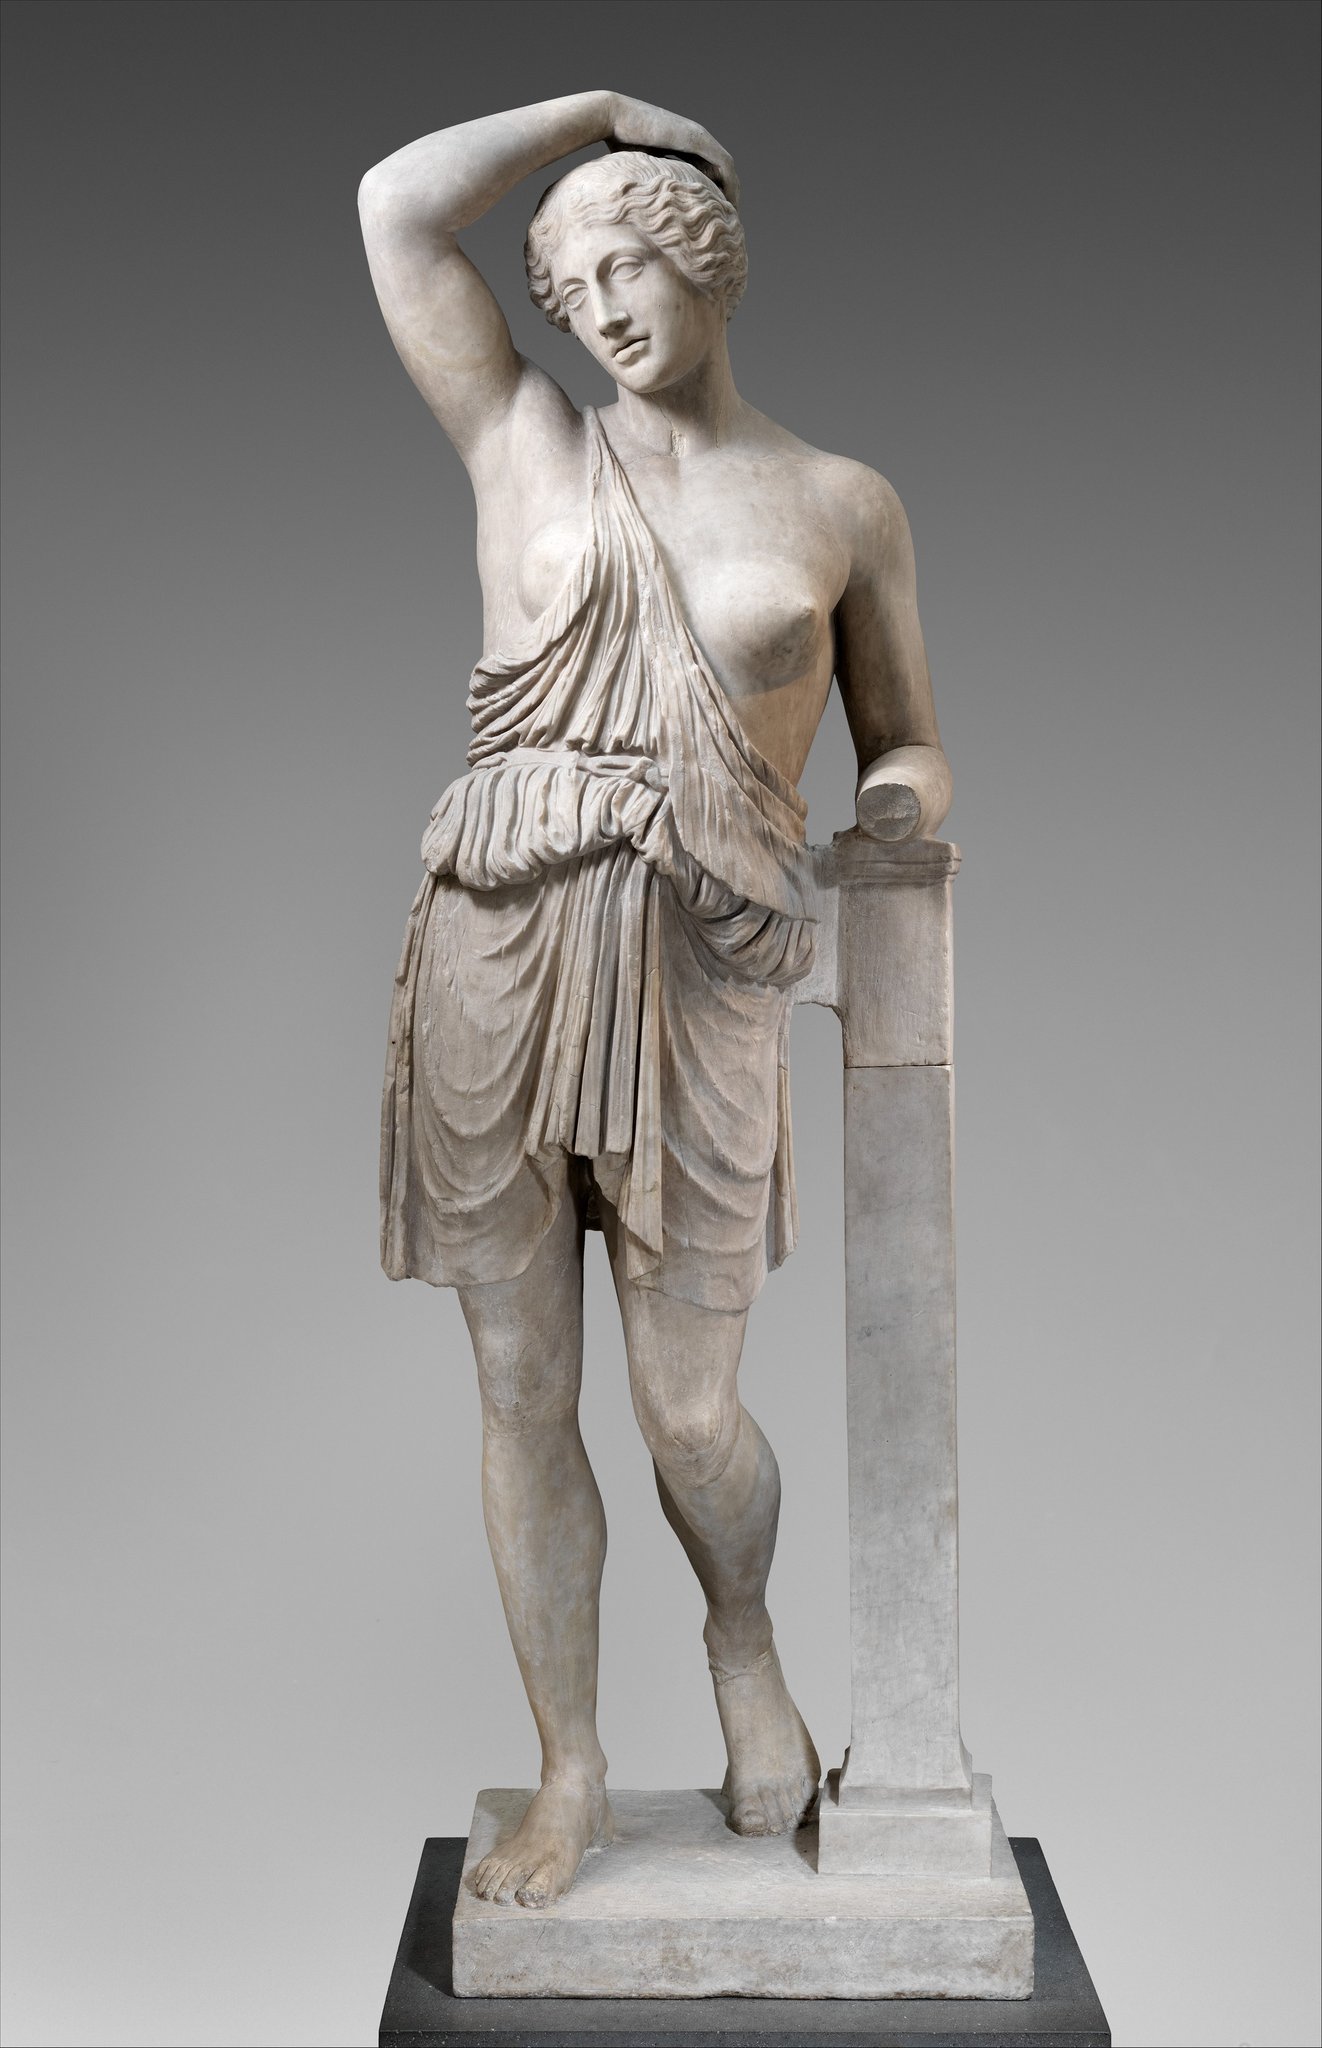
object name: statue of a wounded amazon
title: Marble statue of a wounded Amazon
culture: roman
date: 1-200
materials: marble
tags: women,amazons